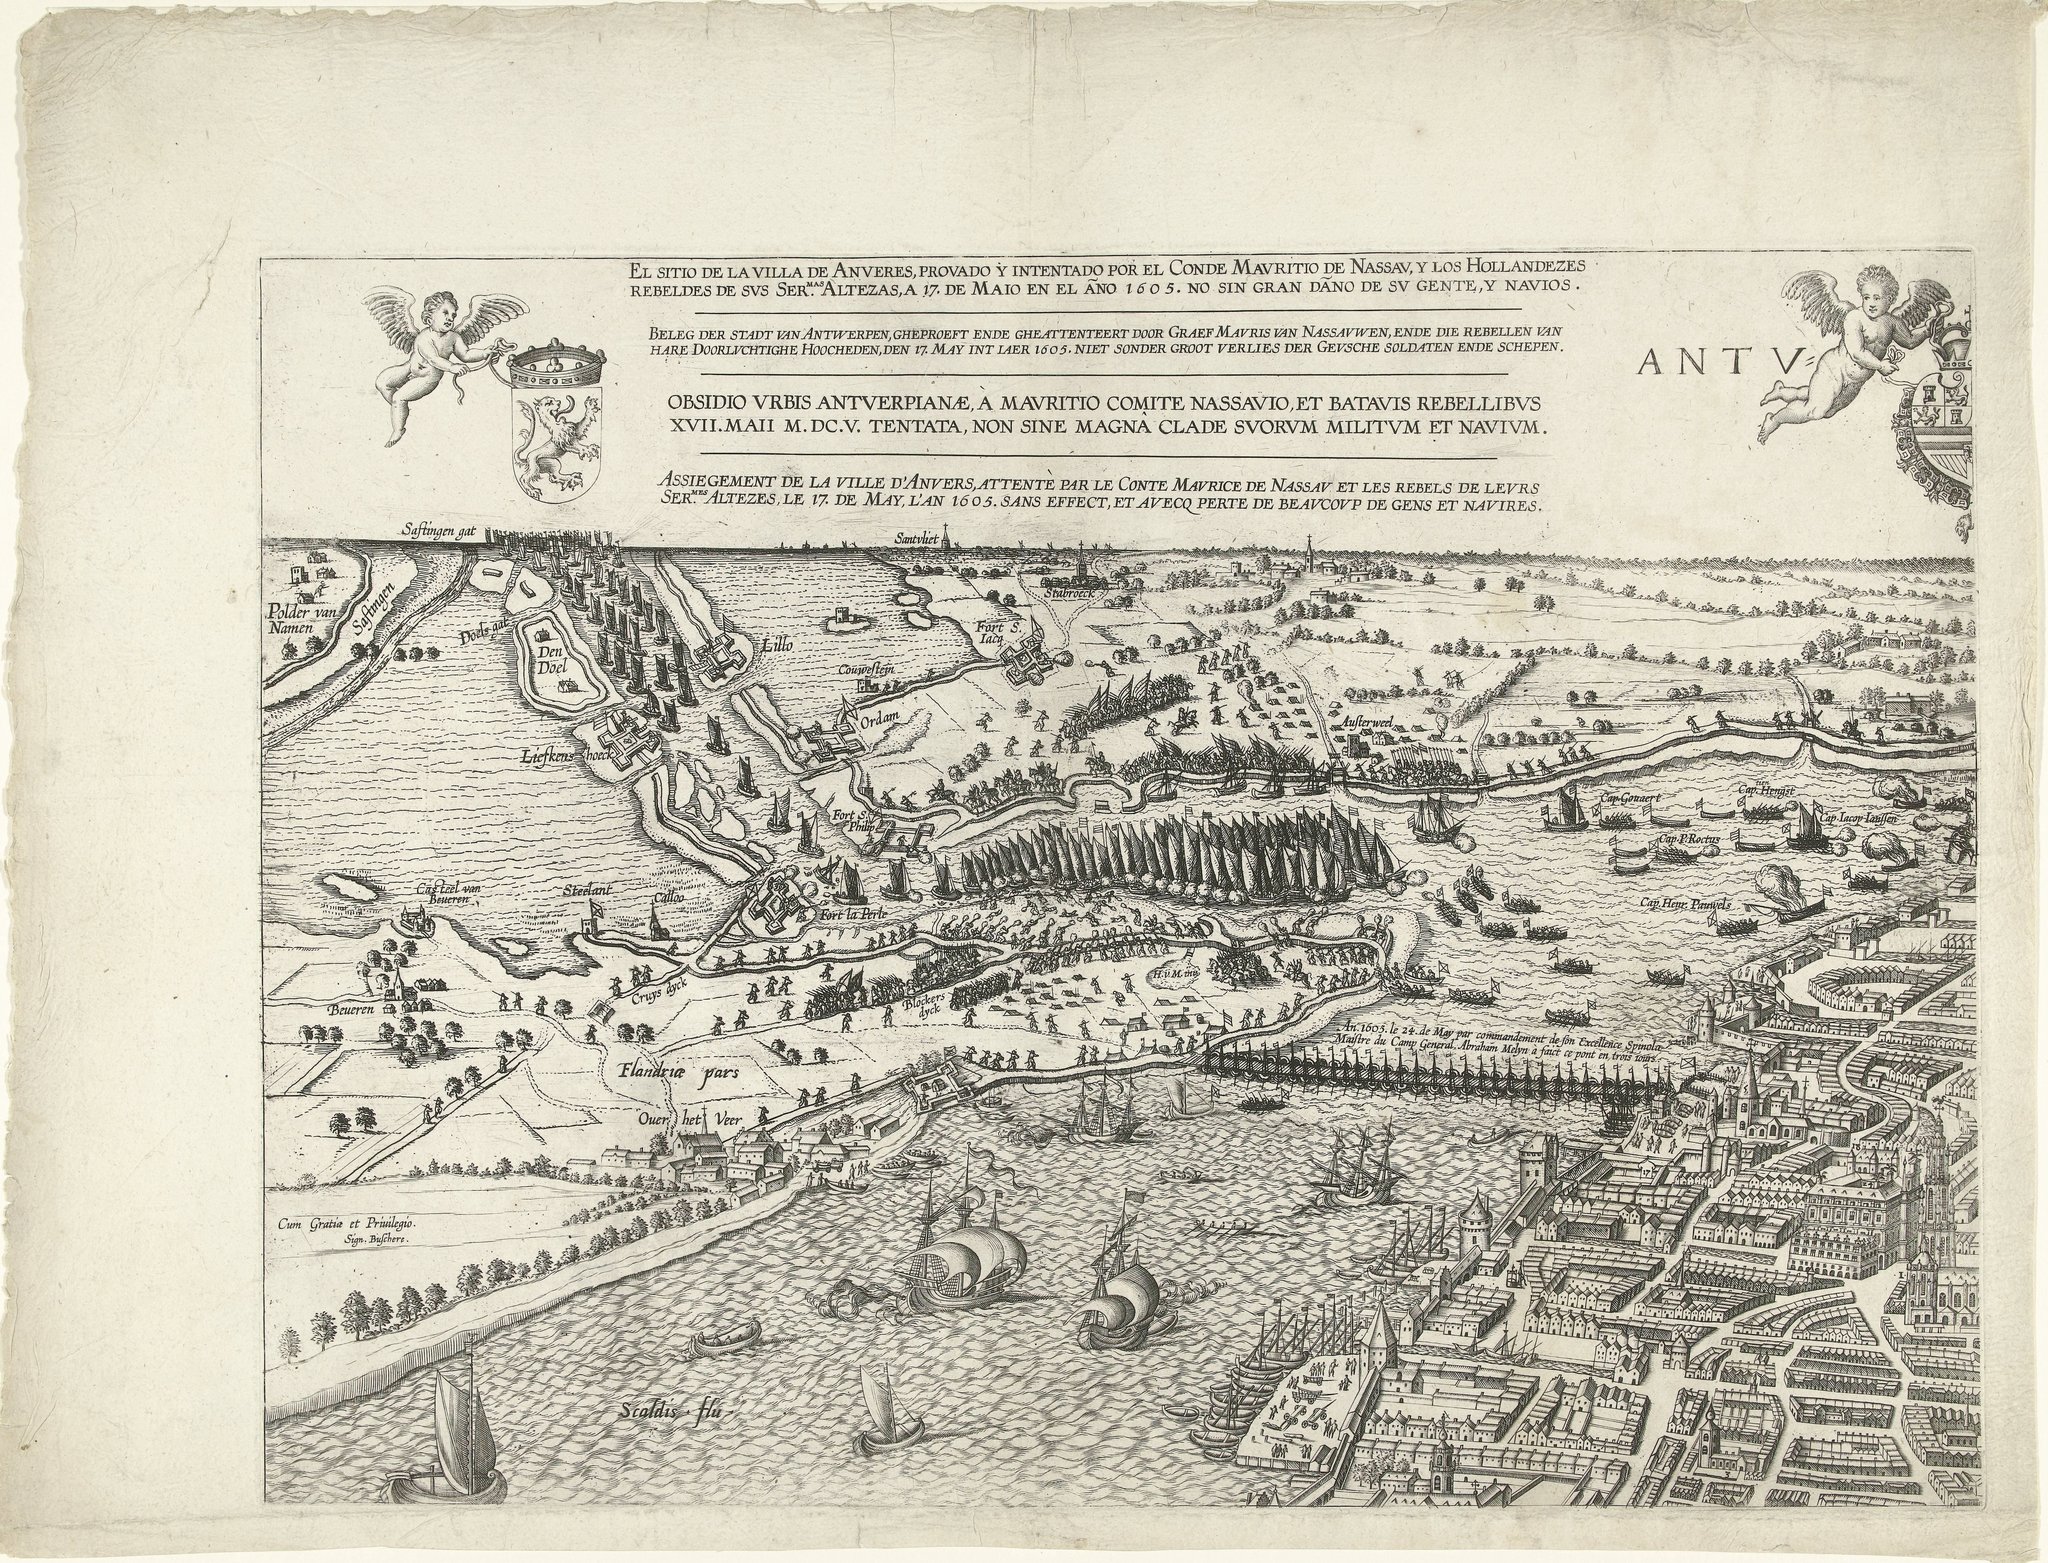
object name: print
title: El sitio de la villa de Anvers, provado y intentado por el conde Mauritio de Nassau, y los Hollandezes rebeldes de sus Ser. mas Altezas, a 17. de maio en el año 1605. No sin gran dano de su gente, y navios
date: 1569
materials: paper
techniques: engraving, etching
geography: antwerp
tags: ernst casimir graaf van nassau-dietz, maps of cities, battle (+ land forces), antwerp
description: Grote kaart van Antwerpen in vogelvlucht met de mislukte aanval door het Staatse leger op Antwerpen, 17 mei 1605. Gevechten op de Schelde tussen de Spaanse boten en de boten in de vloot van graaf Ernst Casimir van Nassau. Verschillende branders op het water, centraal de schipbrug. Linksboven zware gevechten bij de Blokkersdijk. Geheel bestaande uit vier bladen: blad linksboven. Bovenaan de vier titels in het Spaans, Nederlands, Latijn en Frans, een engel met een wapenschild en een engel met de helft van het centrale wapen van Filips II.